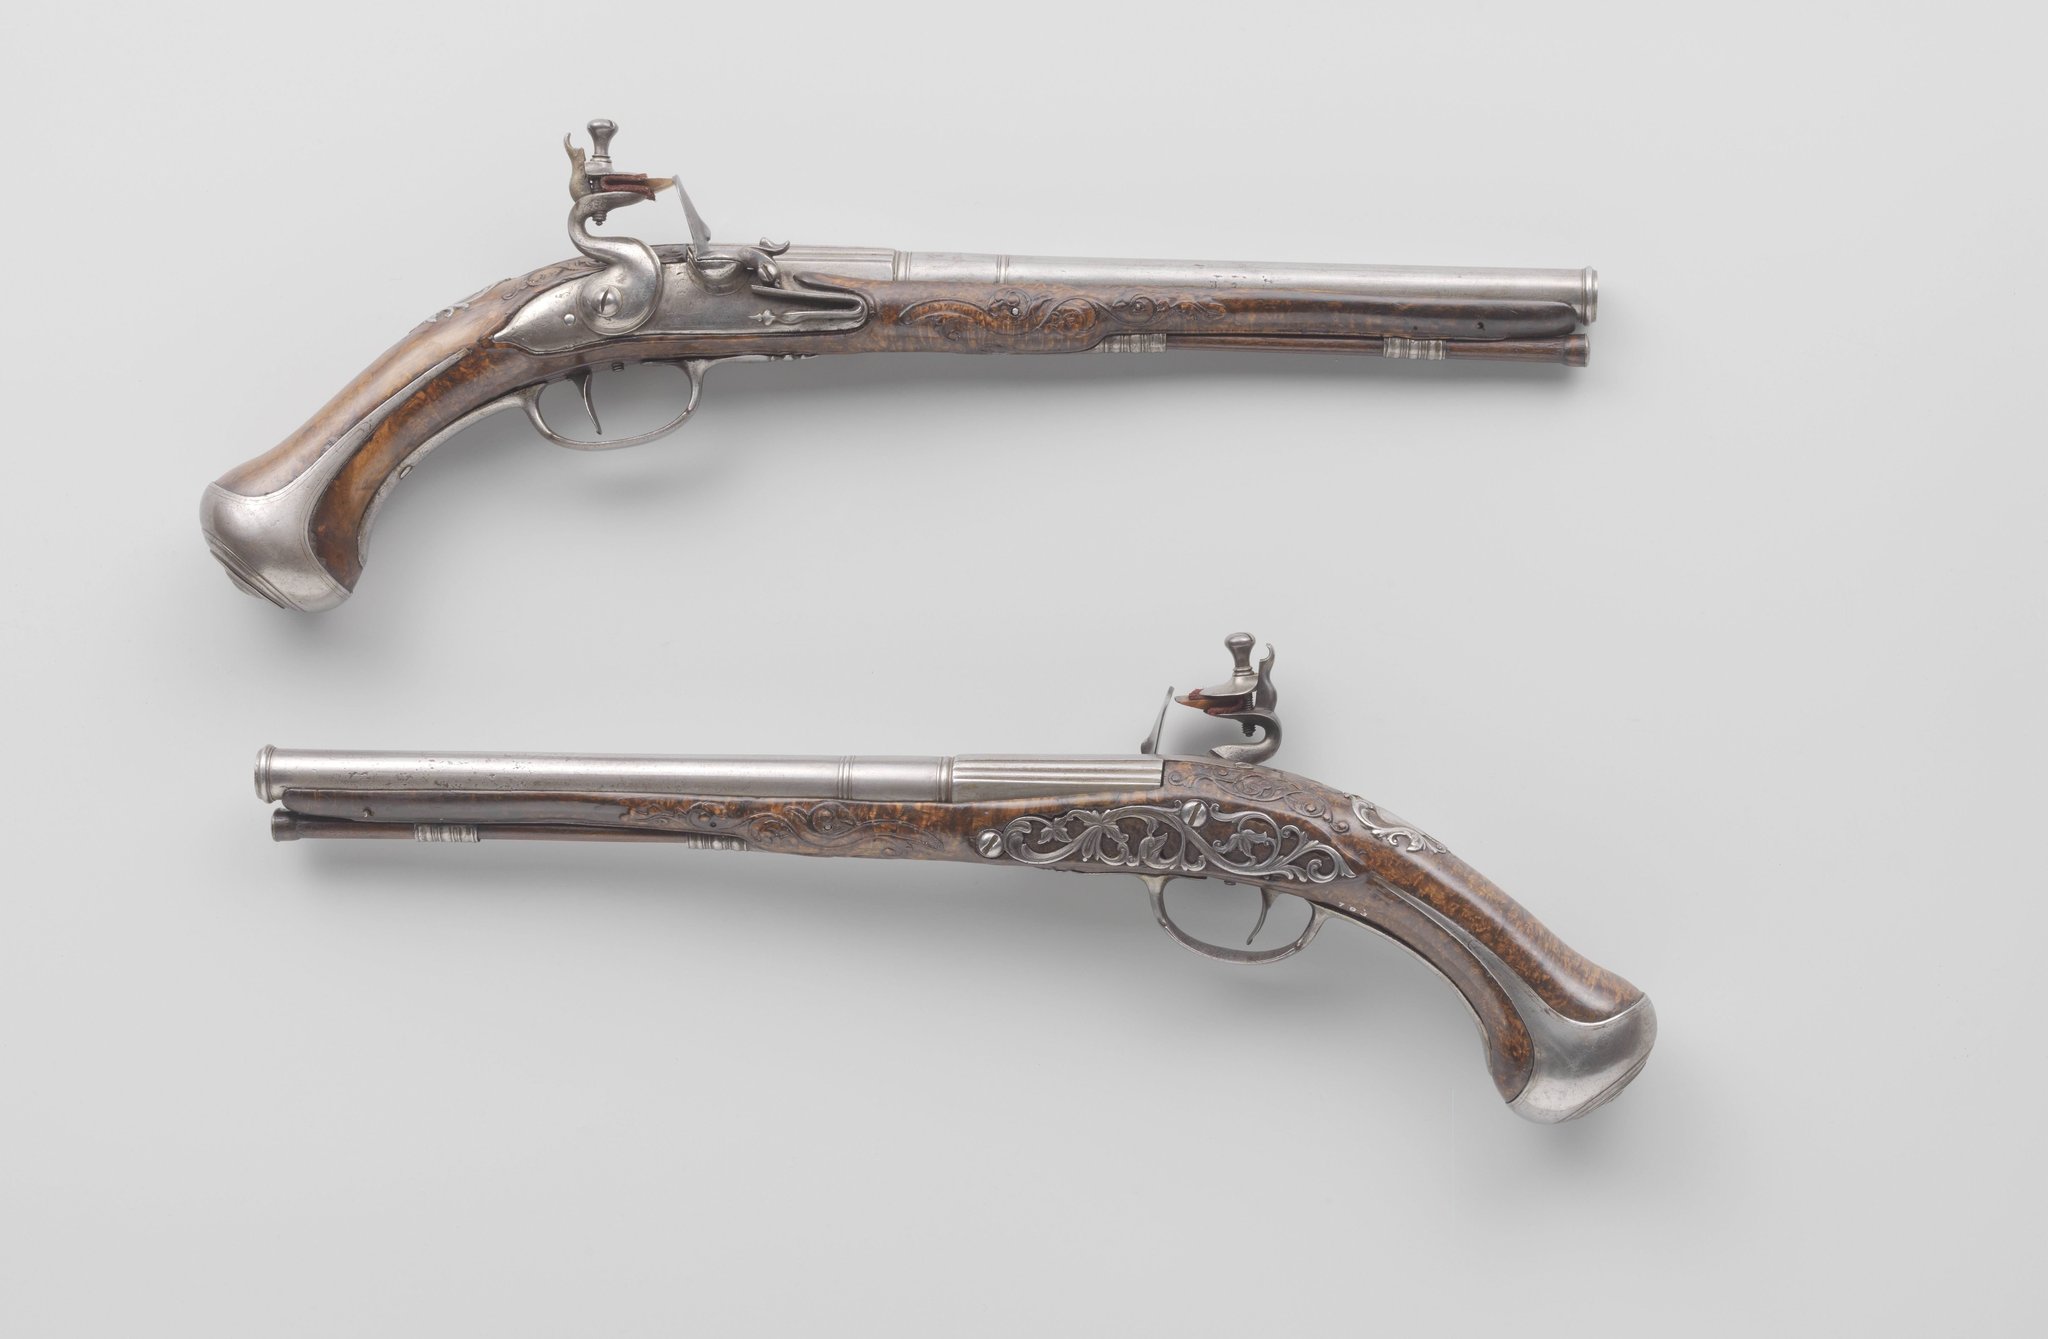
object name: flintlock pistol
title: Vuursteenpistool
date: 1665-1670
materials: iron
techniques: printing, casting, cutting, embroidery, engraving, relief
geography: utrecht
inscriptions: mark: ‘AI’, inscription: ‘IAN KNOOP // UTRECHT’